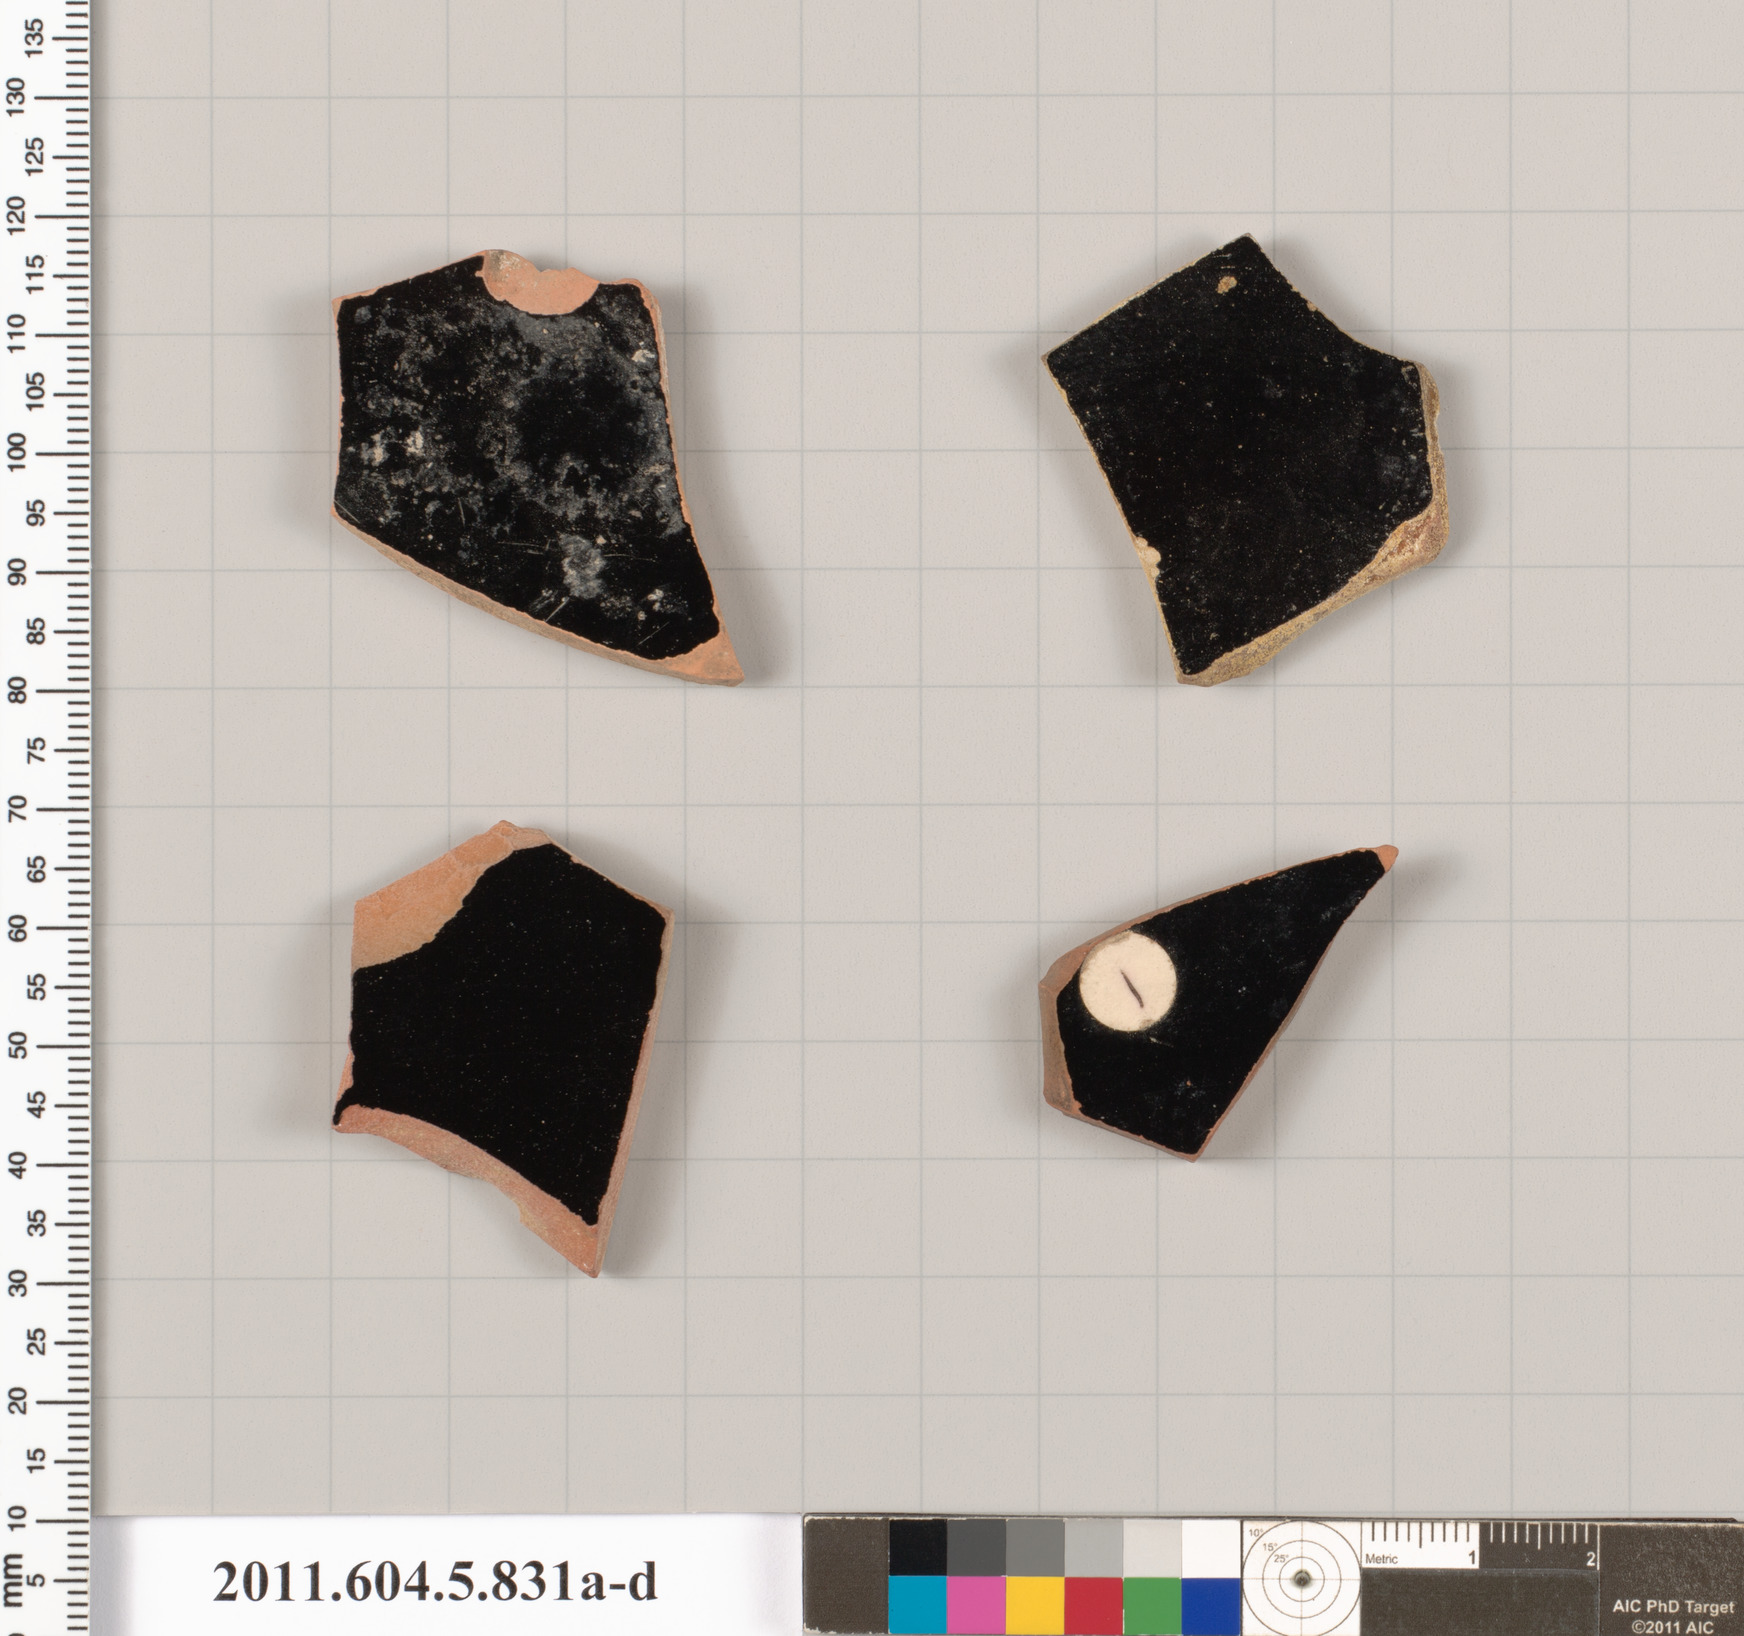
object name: kylix fragment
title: Terracotta fragments of kylikes (drinking cups)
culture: greek, attic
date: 600-401 BCE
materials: terracotta